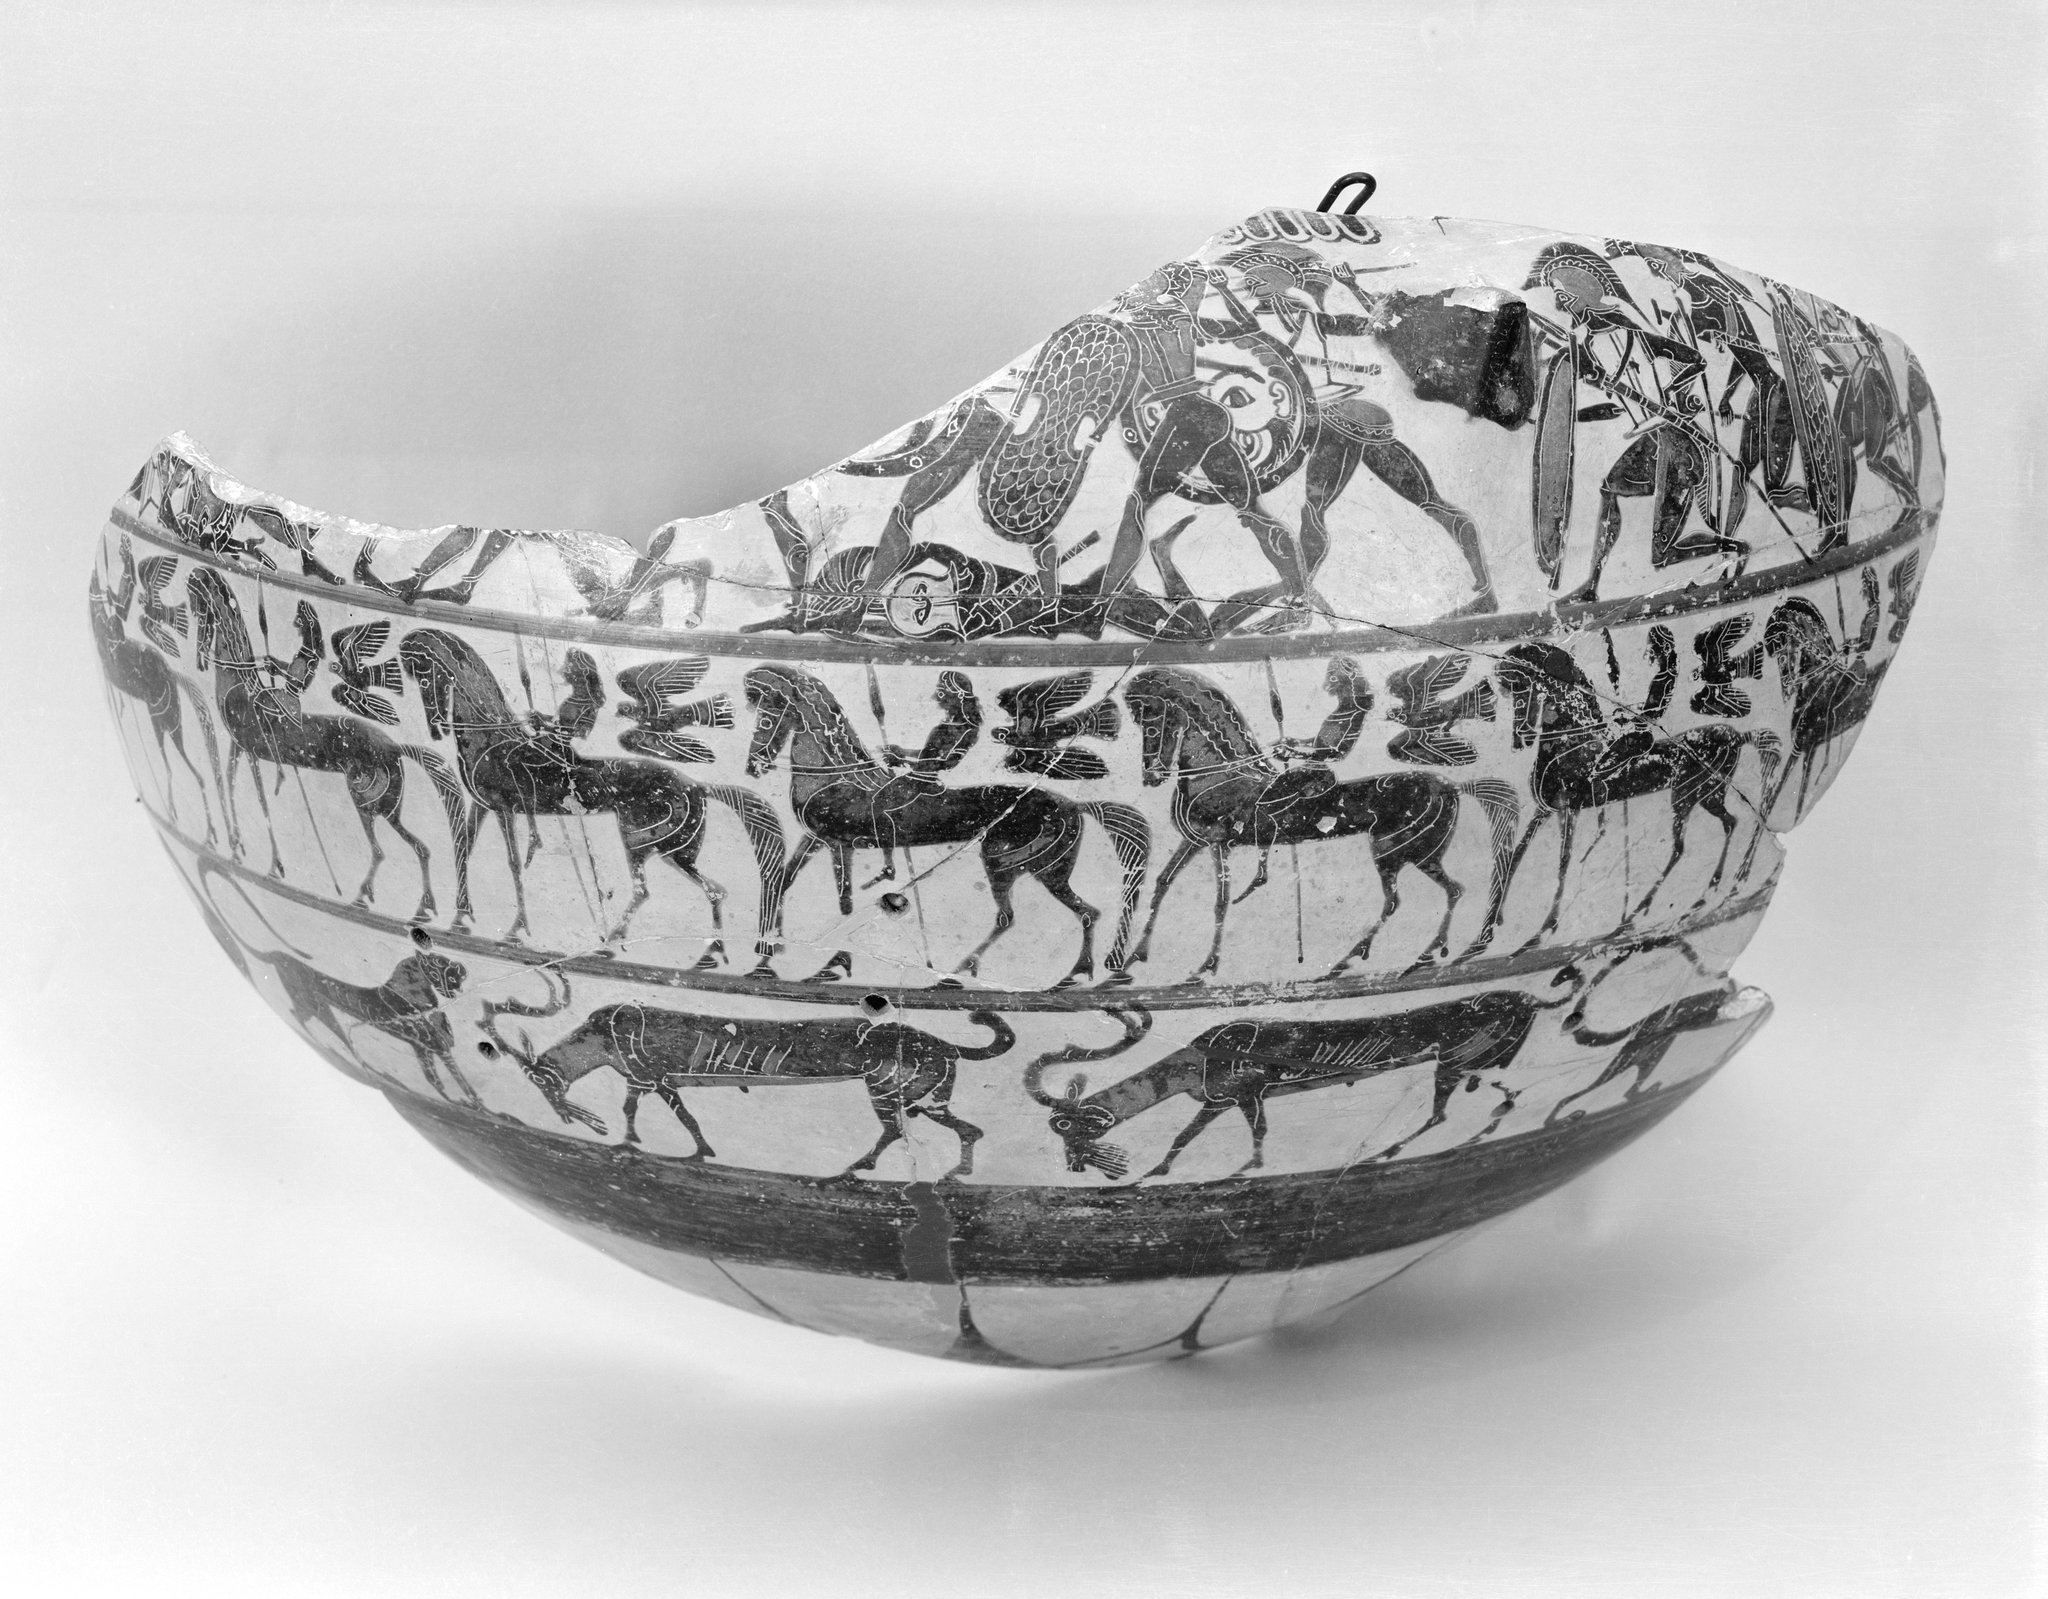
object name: column krater fragment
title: Fragment of a terracotta column-krater (bowl for mixing wine and water)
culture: greek, corinthian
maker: cavalcade painter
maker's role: artist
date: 590-570 BCE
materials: terracotta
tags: animals,birds,men,goats,horses